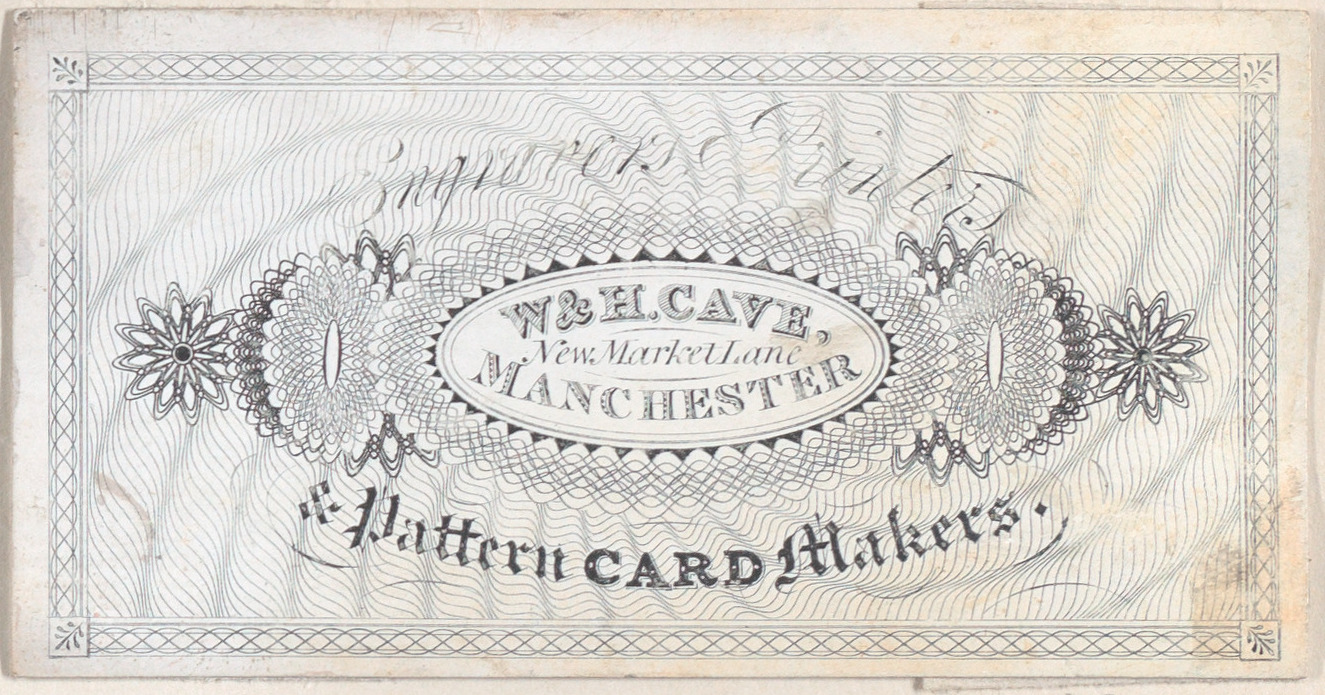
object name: print, trade card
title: Trade card for W&H Cave, Engraver, Printer, and Pattern Card Maker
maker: anonymous, british, 19th century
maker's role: artist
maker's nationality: british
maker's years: 1800-1900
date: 1801-1900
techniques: engraving